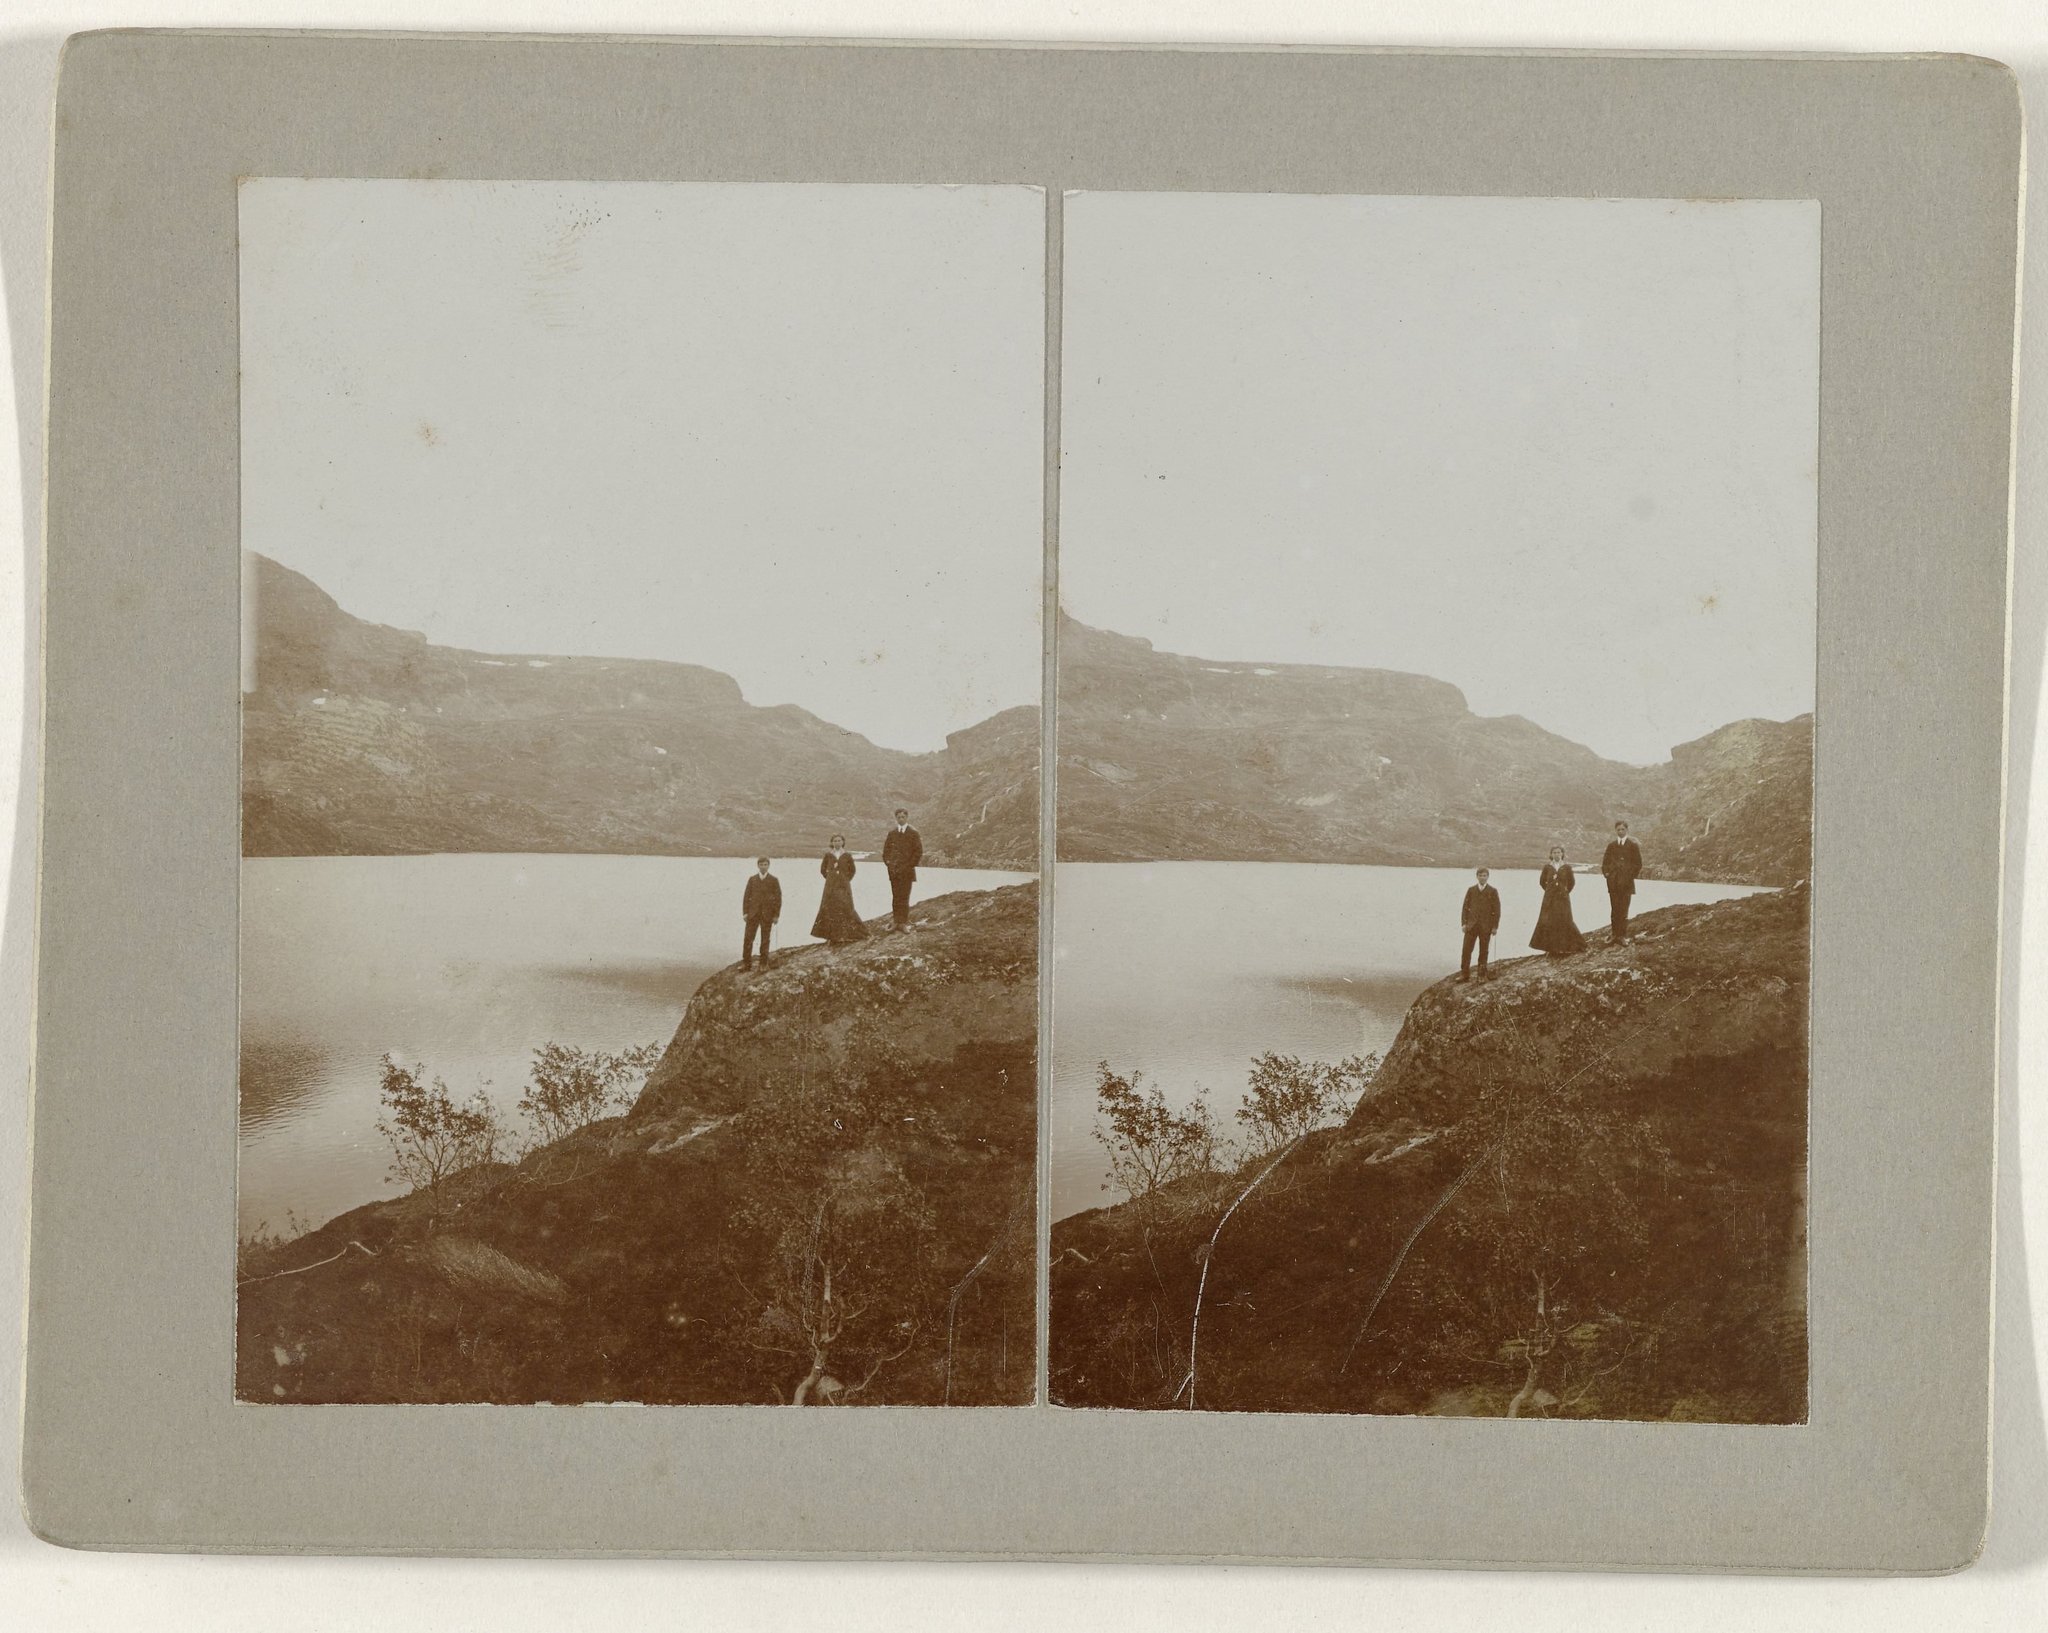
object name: stereograph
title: Portret van drie mensen op een rots aan een Noors meer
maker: geldolph adriaan kessler (dolph)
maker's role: fotograaf, industrieel, voetballer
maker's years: 1884-1945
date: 1909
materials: paper, photographic support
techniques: collodion silver print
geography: austria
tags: norway